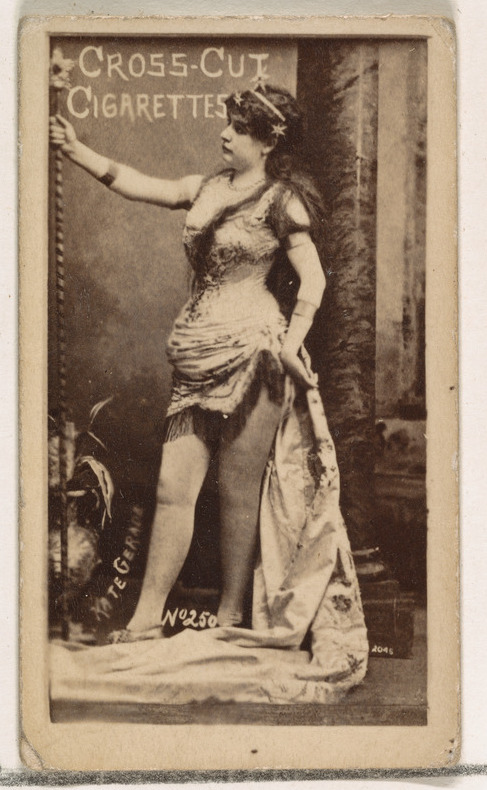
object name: print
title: Card Number 250, Kate Gerade, from the Actors and Actresses series (N145-1) issued by Duke Sons & Co. to promote Cross Cut Cigarettes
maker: w. duke, sons & co.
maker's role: publisher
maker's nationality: american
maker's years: 1870-1920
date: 1880-1889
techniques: albumen silver print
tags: profiles,women,actresses